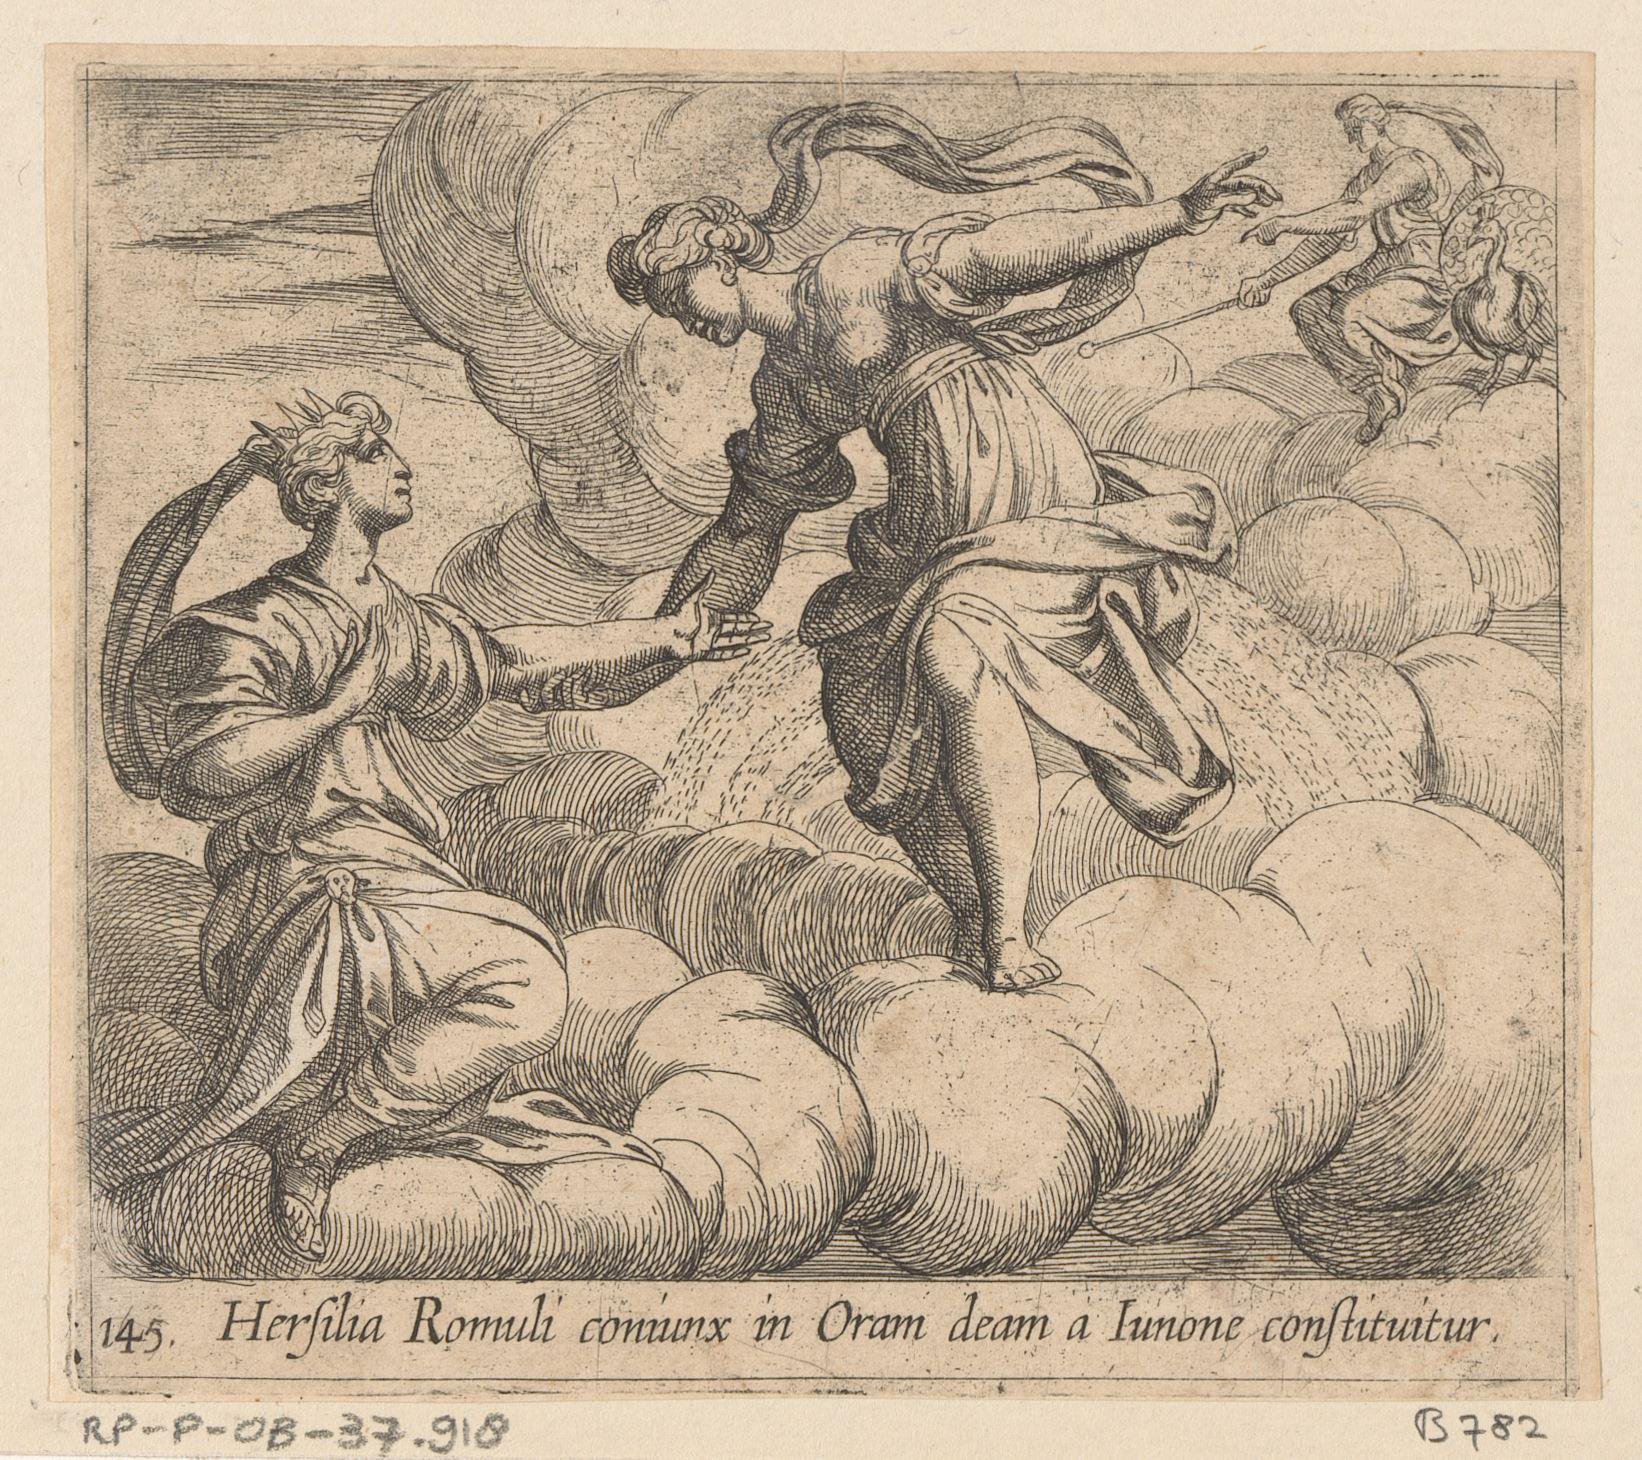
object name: print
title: Hersilia Romuli coniunx in Oram deam a Iunone constituitur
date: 1606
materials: paper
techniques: etching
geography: italy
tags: apotheosis of hersilia: the wife of romulus is taken up to heaven by juno and isis, and becomes the goddess hora quirina, (story of) hersilia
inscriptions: collector's mark: Lugt 240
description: Deze prent maakt deel uit van een reeks van 150 prenten (+ titelprent) met voorstellingen van de Metamorfosen van Ovidius.